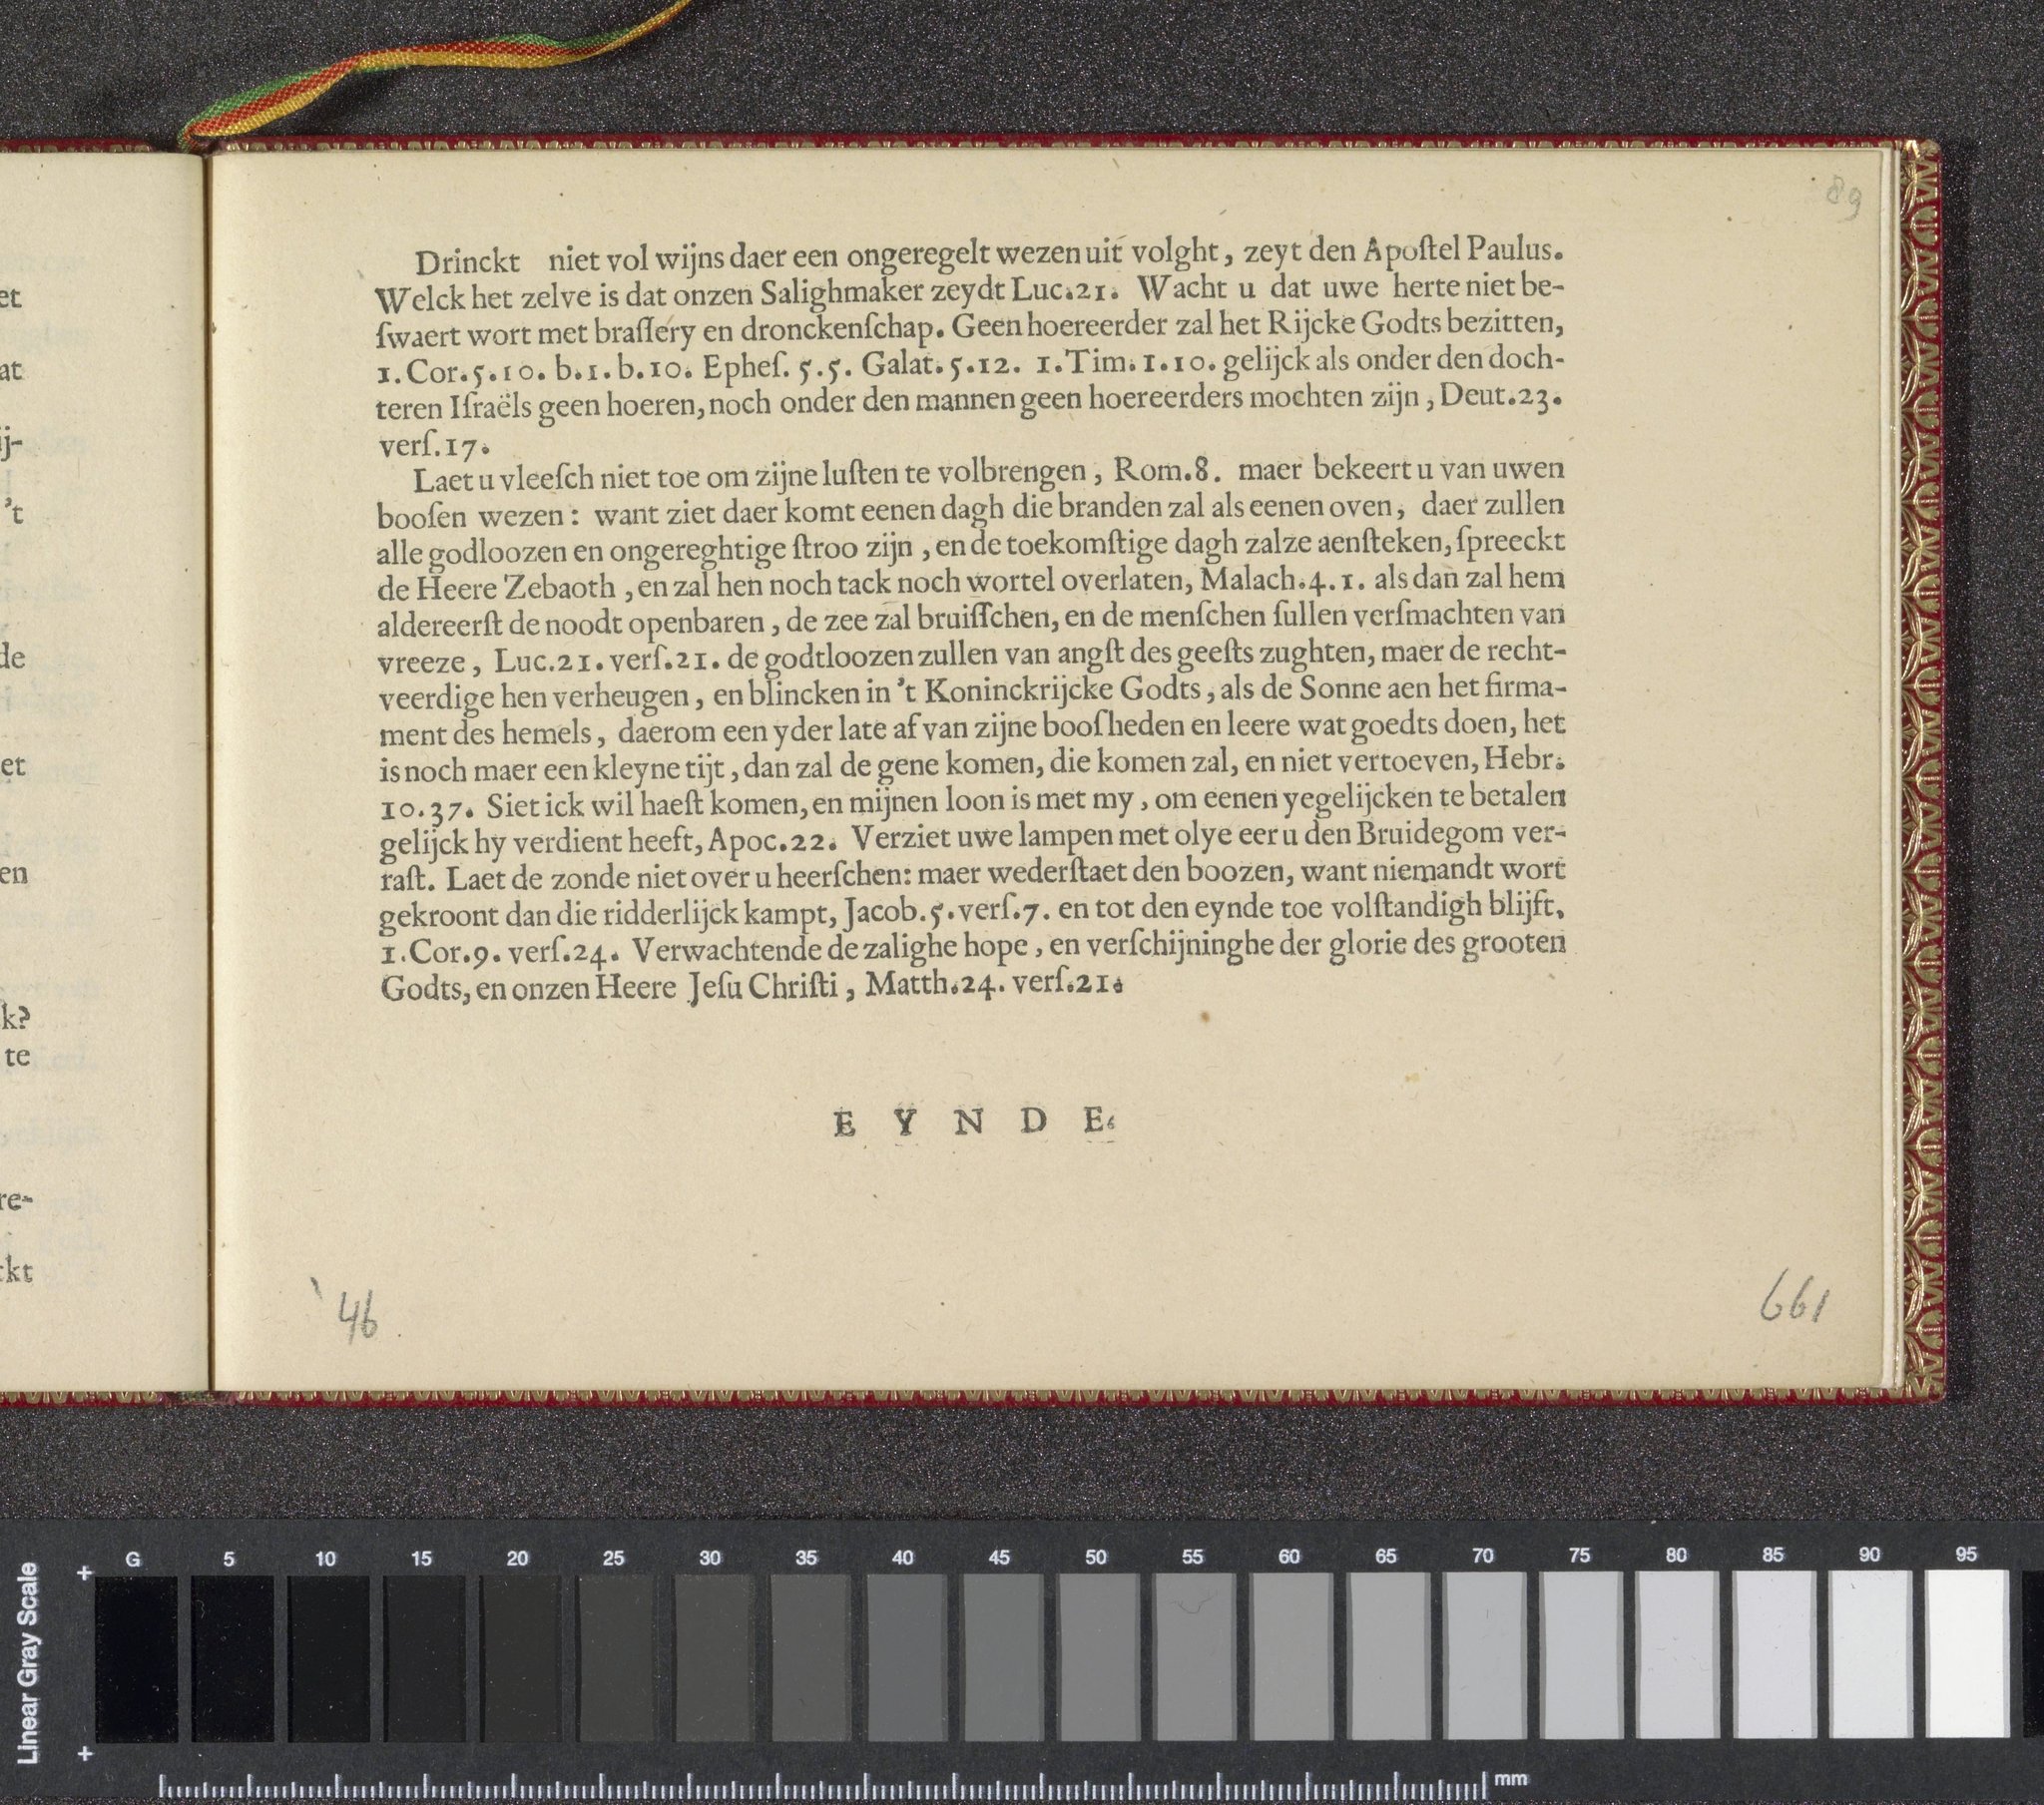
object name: text sheet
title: Waarschuwing, pagina 5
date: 1641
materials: paper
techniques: letterpress printing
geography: amsterdam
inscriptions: date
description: Waarschuwing op vijf pagina's: pagina 5. Het blad maakt deel uit van een album.